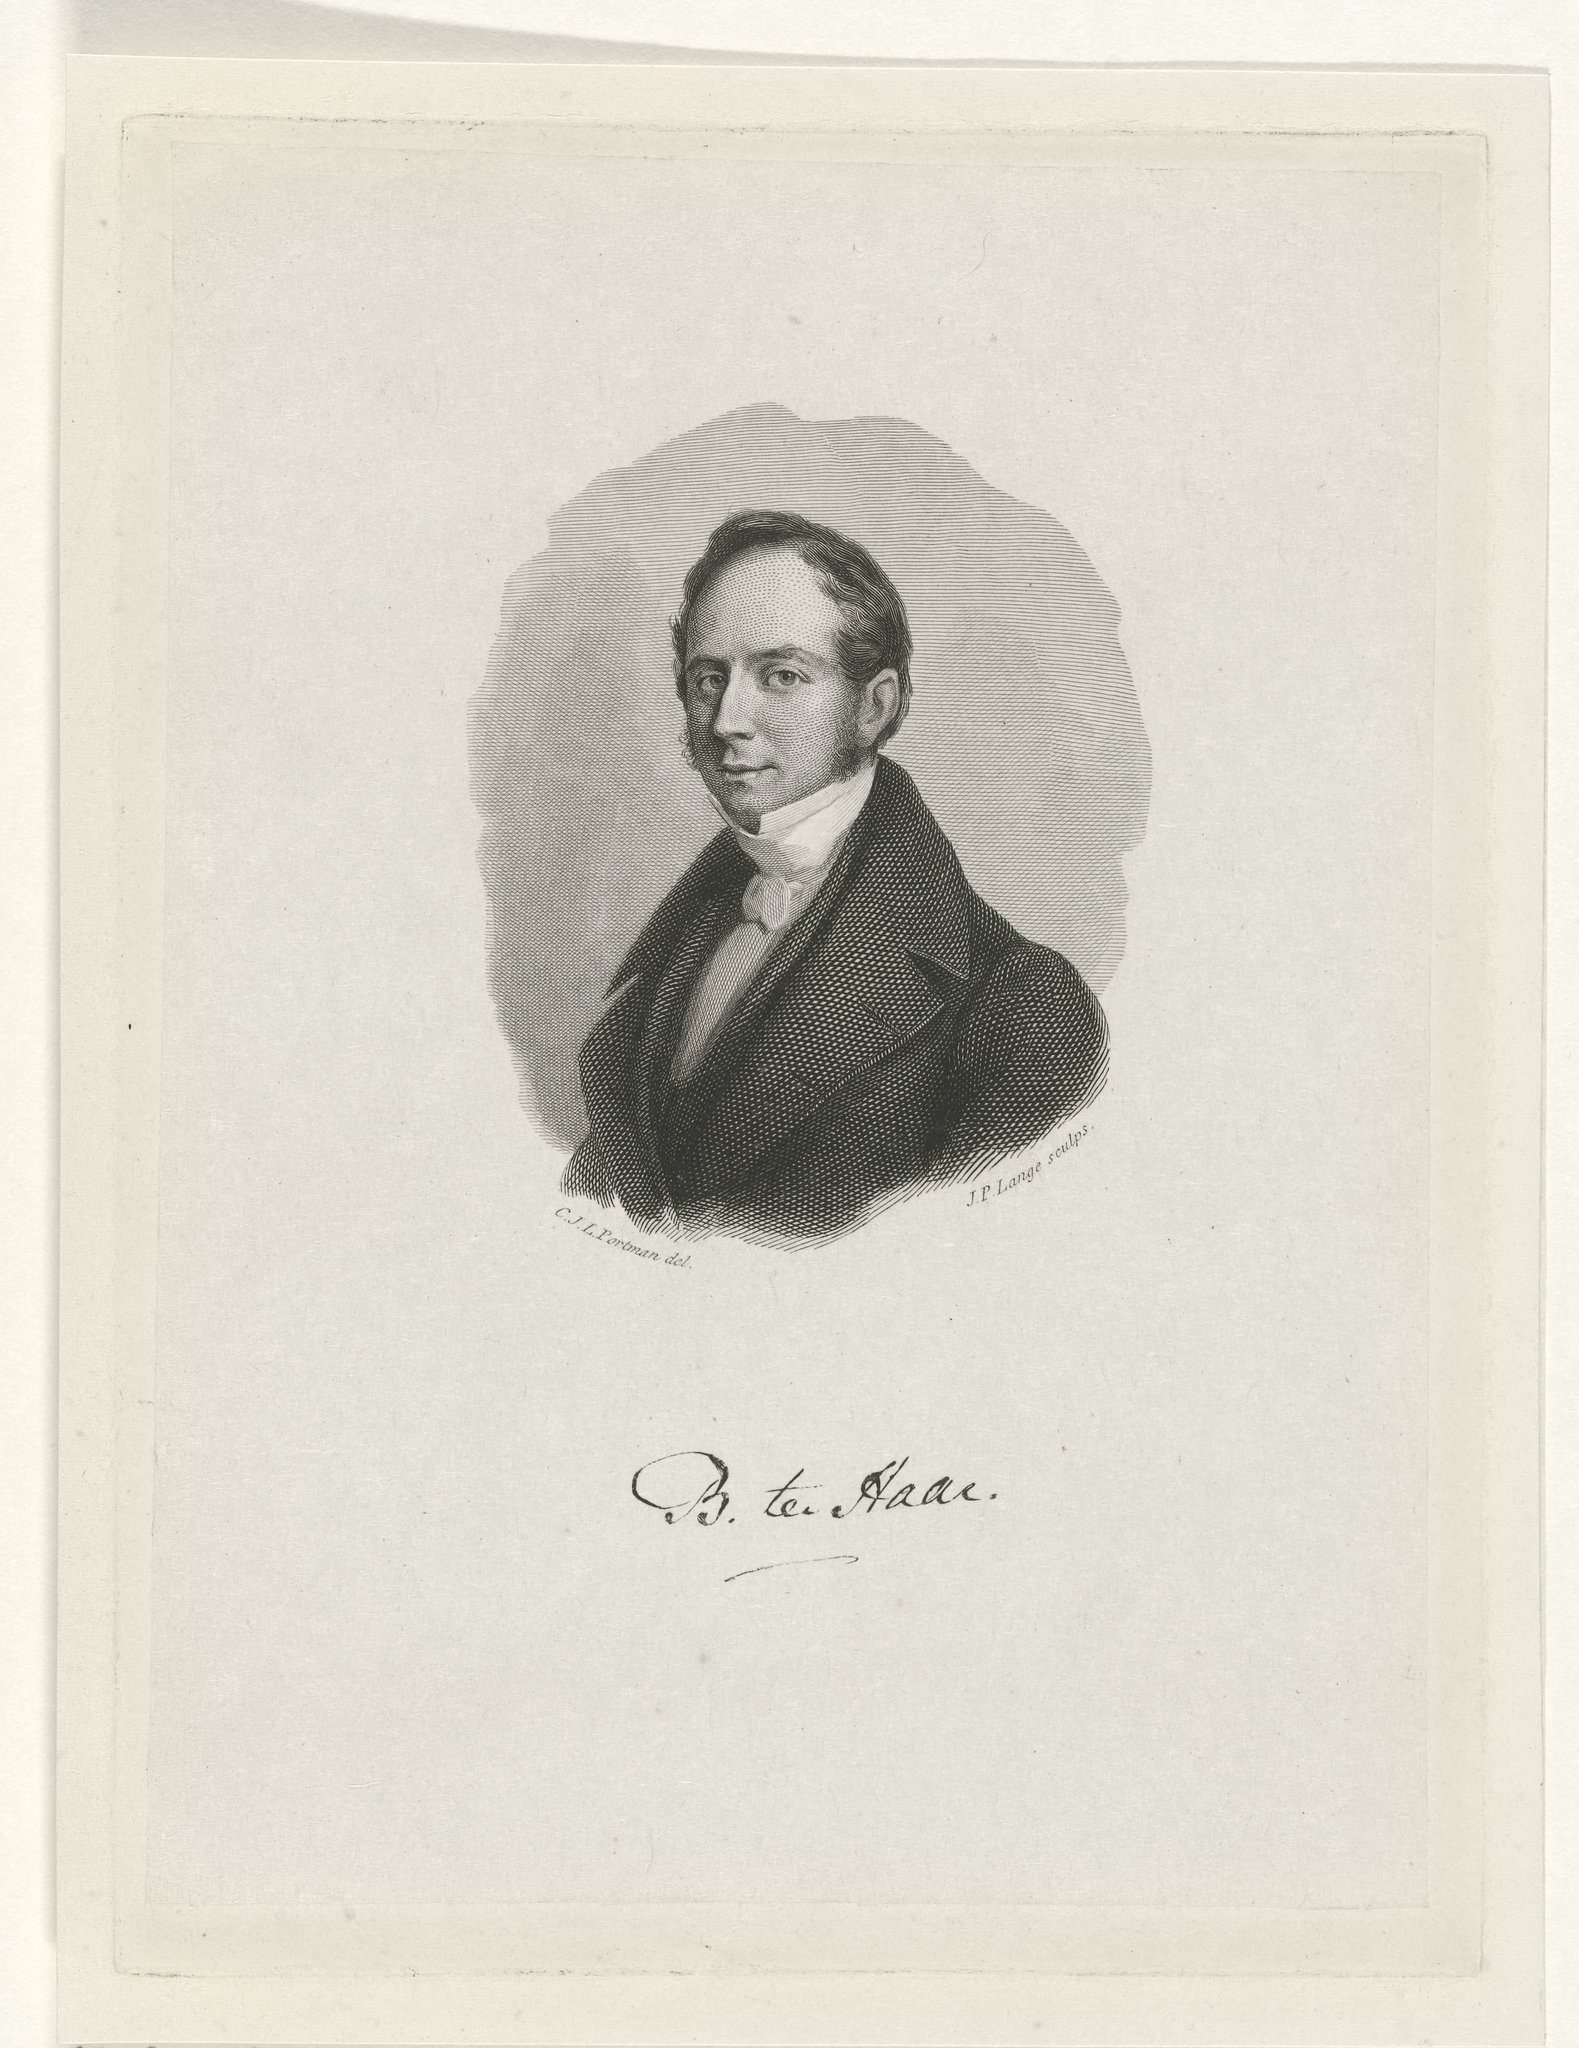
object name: print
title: B. ter Haar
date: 1841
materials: paper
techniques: engraving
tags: bernard ter haar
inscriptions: collector's mark: Lugt 2228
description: Portretbuste naar links van Bernhard ter Haar, dichter en hervormd predikant te Arnhem en Amsterdam.